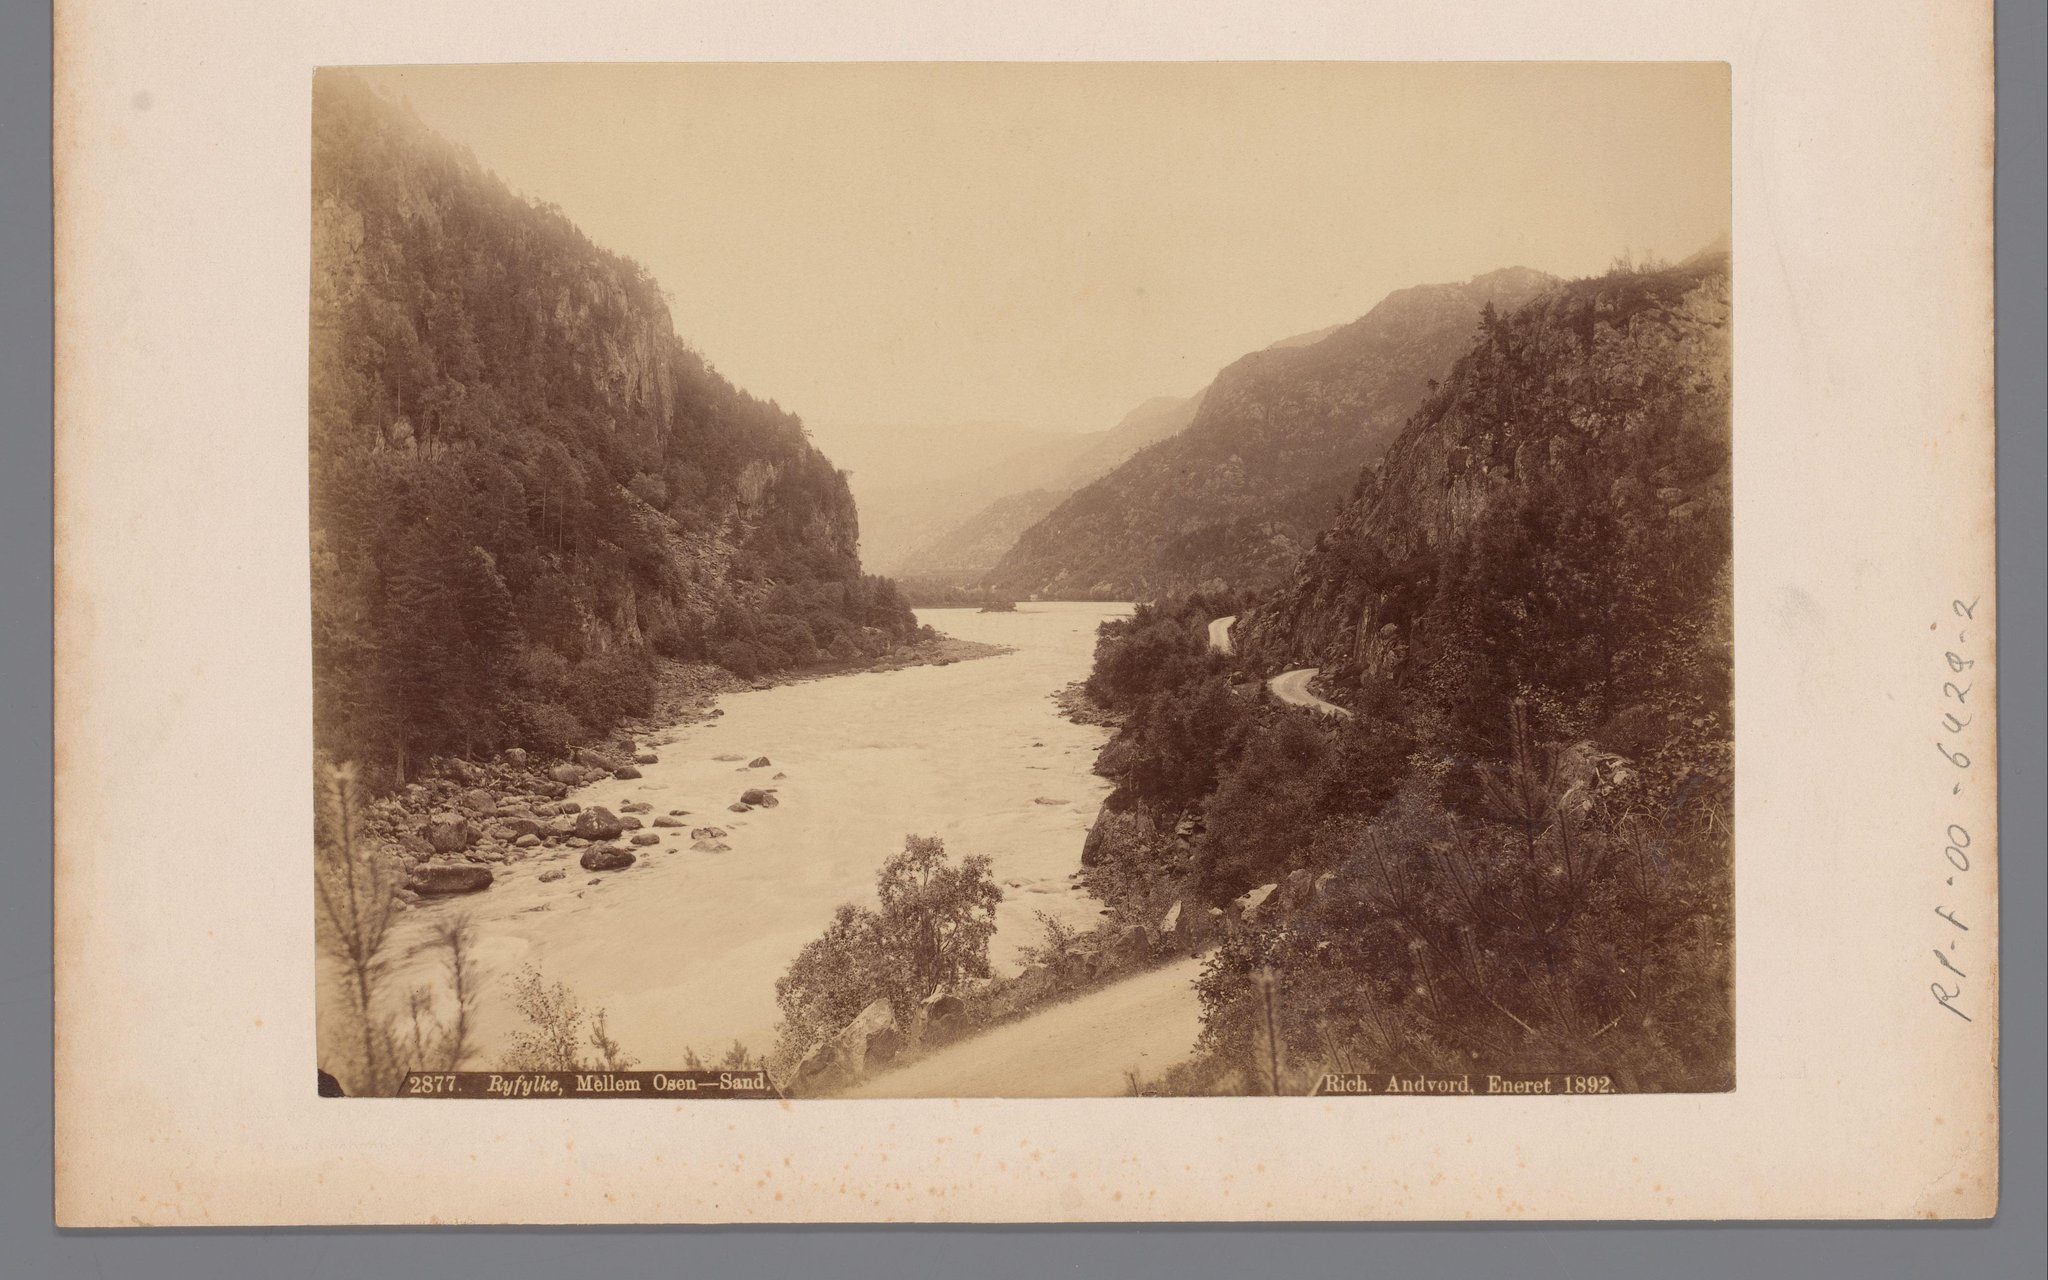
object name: photograph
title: Ryfylke, Mellem-Osen, Sand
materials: cardboard, photographic support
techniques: albumen print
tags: norway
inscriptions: caption: ‘2877. Ryfylke, Mellem-Osen, Sand,’, inscription: ‘Rich. Andvord. Eneret 1892.’